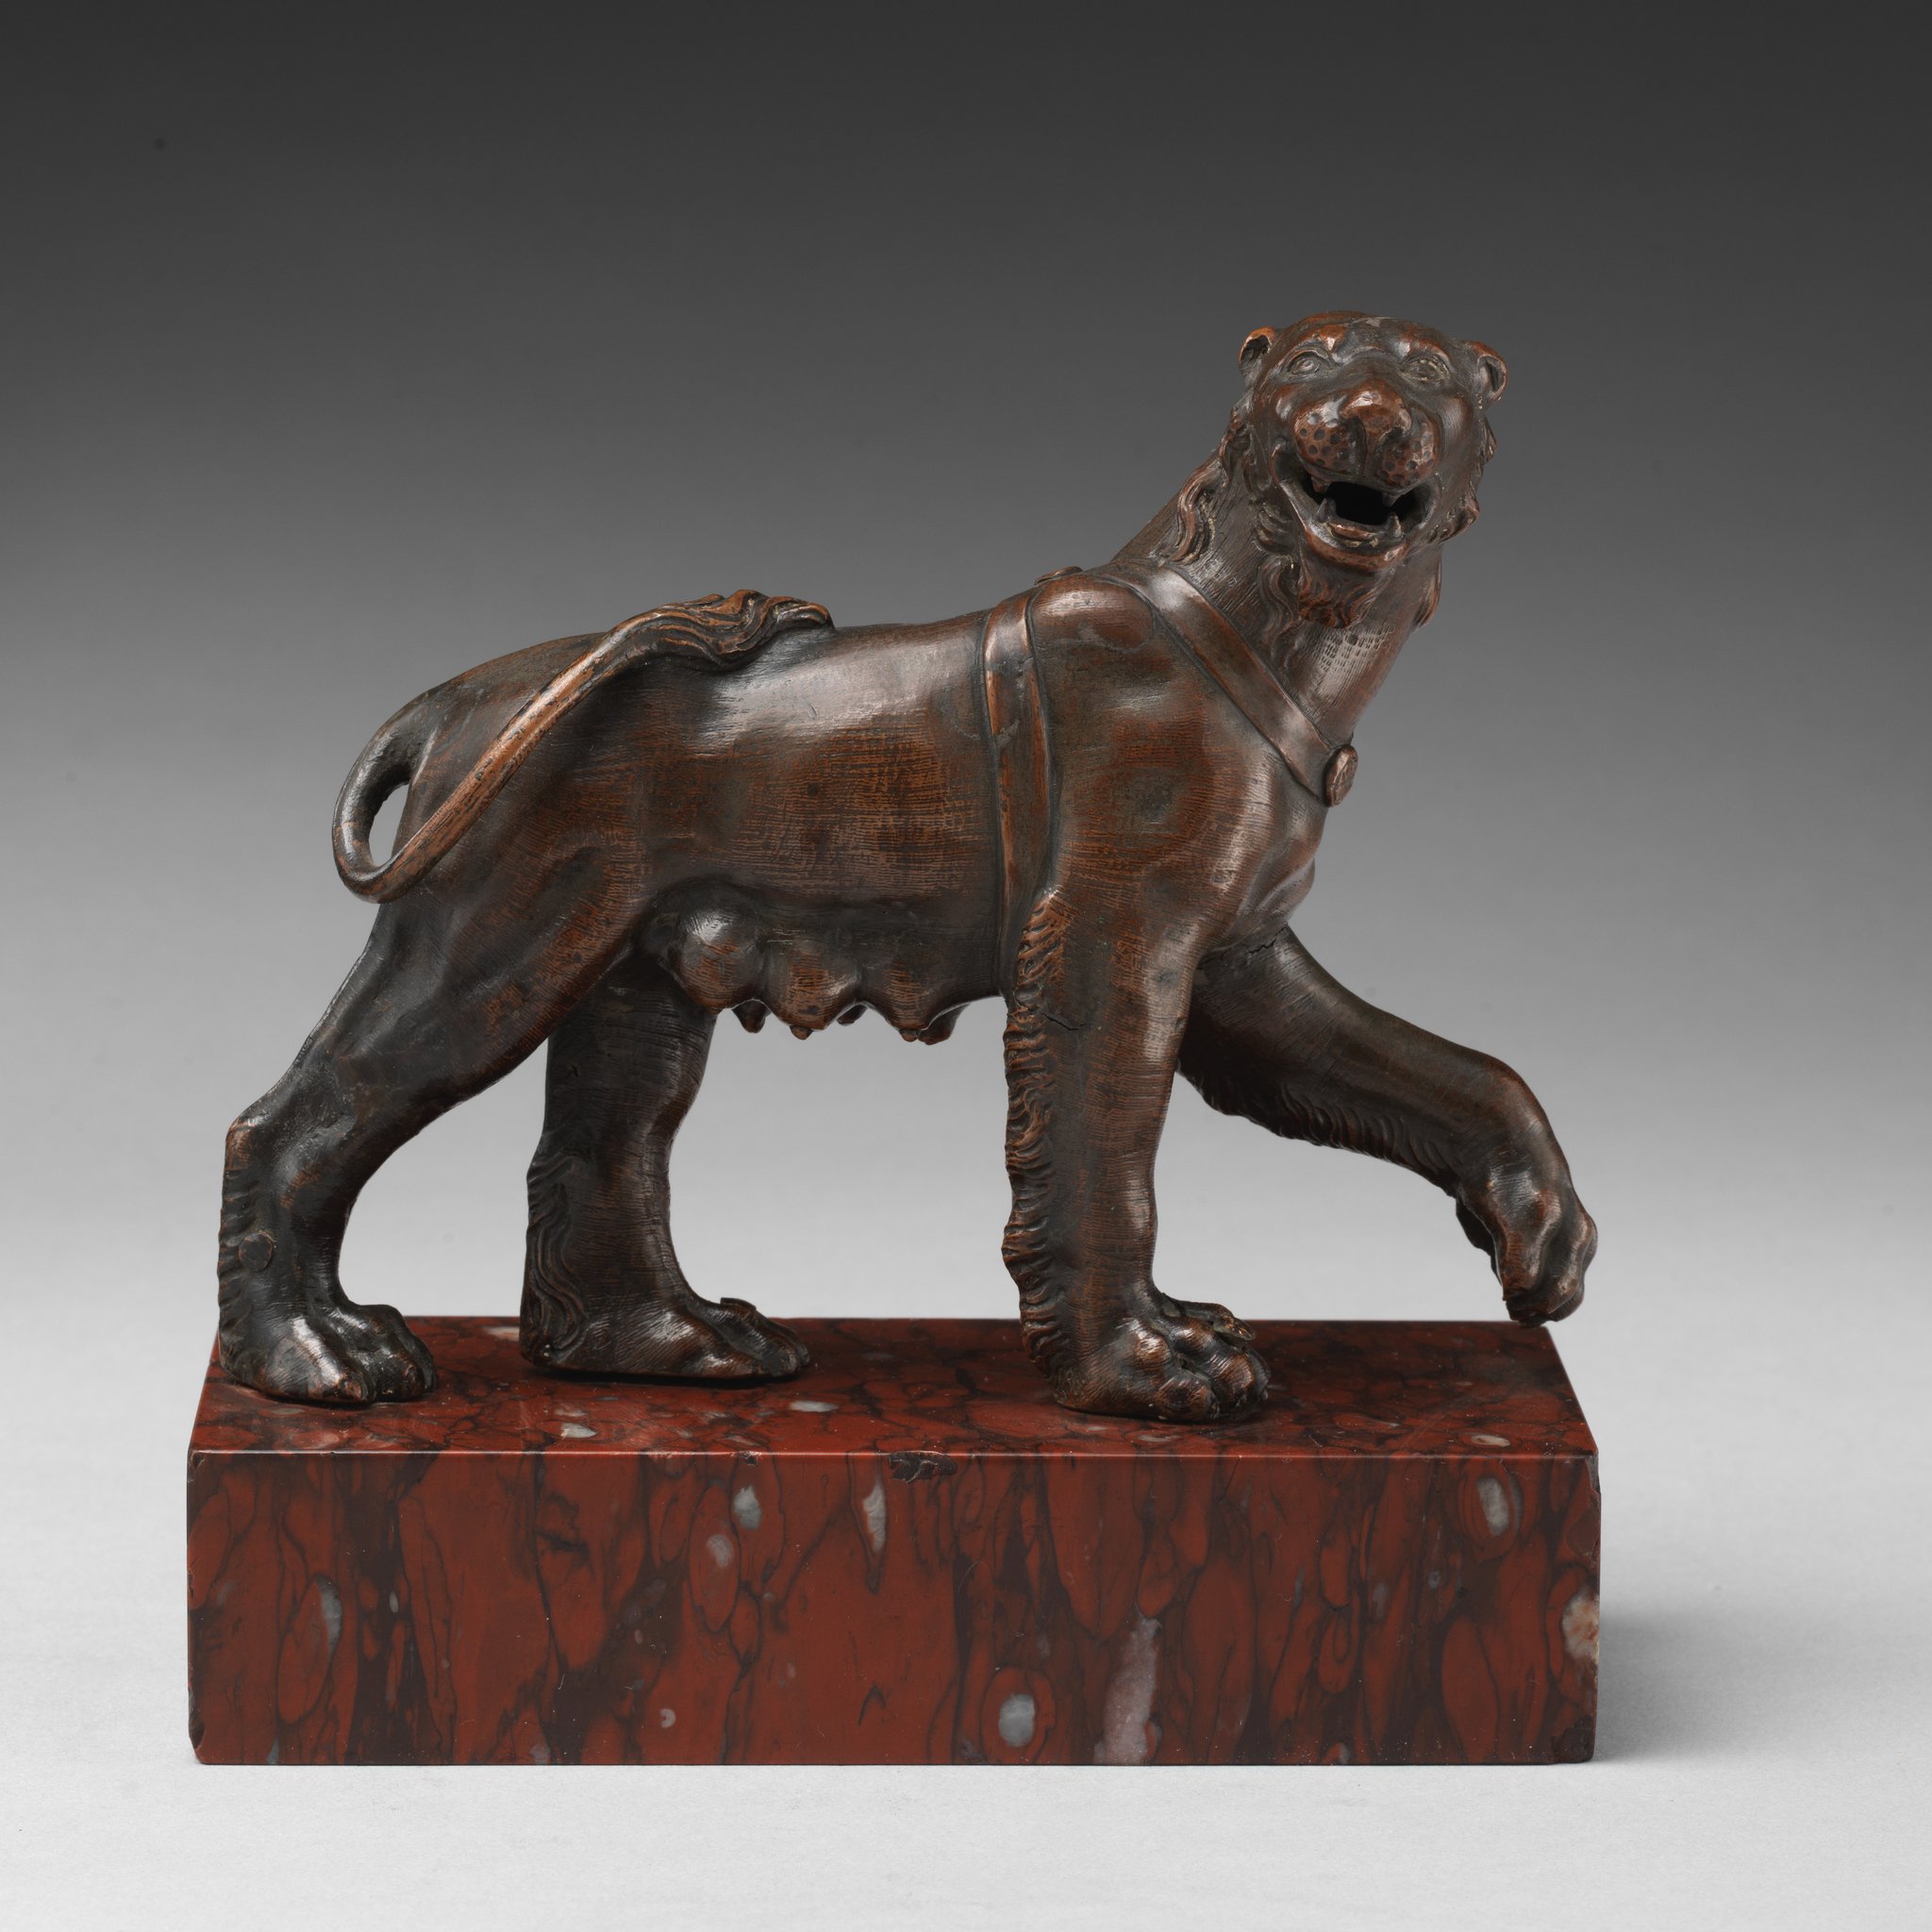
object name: statuette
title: Female panther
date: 1601-1700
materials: bronze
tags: animals